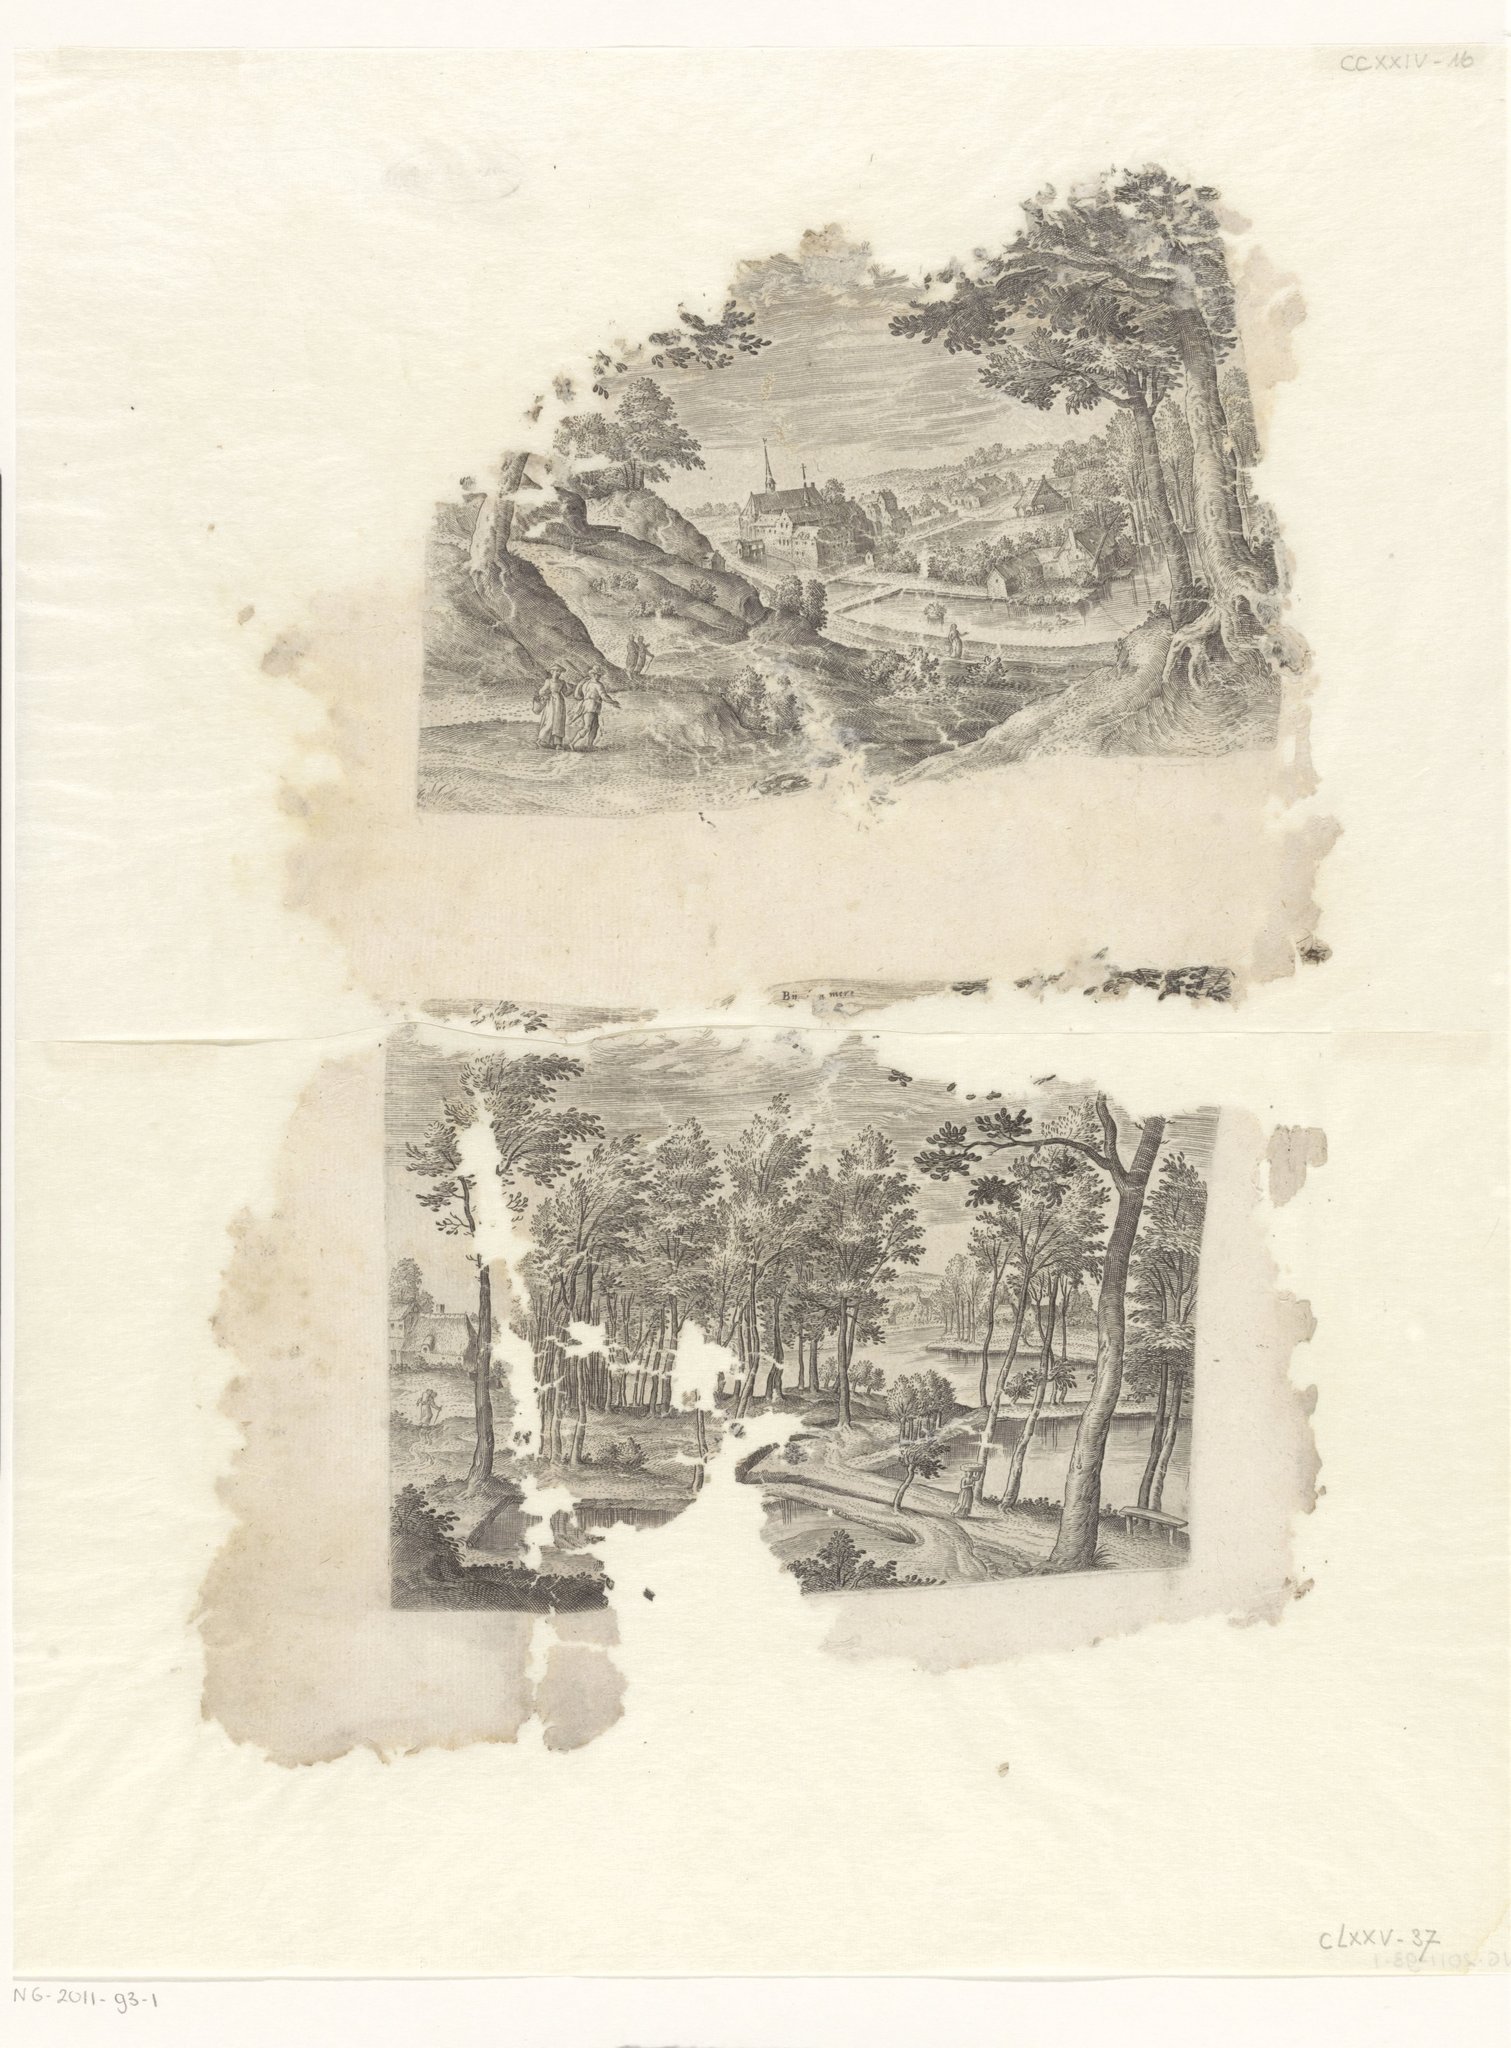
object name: print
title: Seuen burre / Bij Camere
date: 1575-1580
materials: paper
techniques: engraving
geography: southern netherlands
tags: city-view, and landscape with man-made constructions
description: Prenten zijn onderdeel van een serie van 24. De prenten in de Nova Zembla collectie zijn tijdens een expeditie van Willem Barendsz en Jacob van Heemskerk in 1596-1597 noodgedwongen in het winterkamp, het ‘Behouden Huis’, op het eiland achtergelaten. De prenten waren in één of meerdere stapels als handelswaar meegenomen vanuit Amsterdam. Bijna drie eeuwen later, in 1871, keerde de Noor Elling Carlsen terug naar Nova Zembla en vond daar de restanten van het ‘Behouden Huis, inclusief een groot deel van de inventaris. Een deel van de prenten, in de vorm van aaneengekoekte kluiten, werd toen ook teruggevonden. De papierkluiten waren soms op meerdere plekken gebroken. Tussen 1975-1979 zijn de prenten van elkaar gescheiden. Dit leverde in totaal ca. 1000 fragmenten van ca. 400 afdrukken van ca. 150 verschillende prenten op. Voor zover mogelijk zijn de fragmenten samengevoegd en zijn de prenten gereconstrueerd.